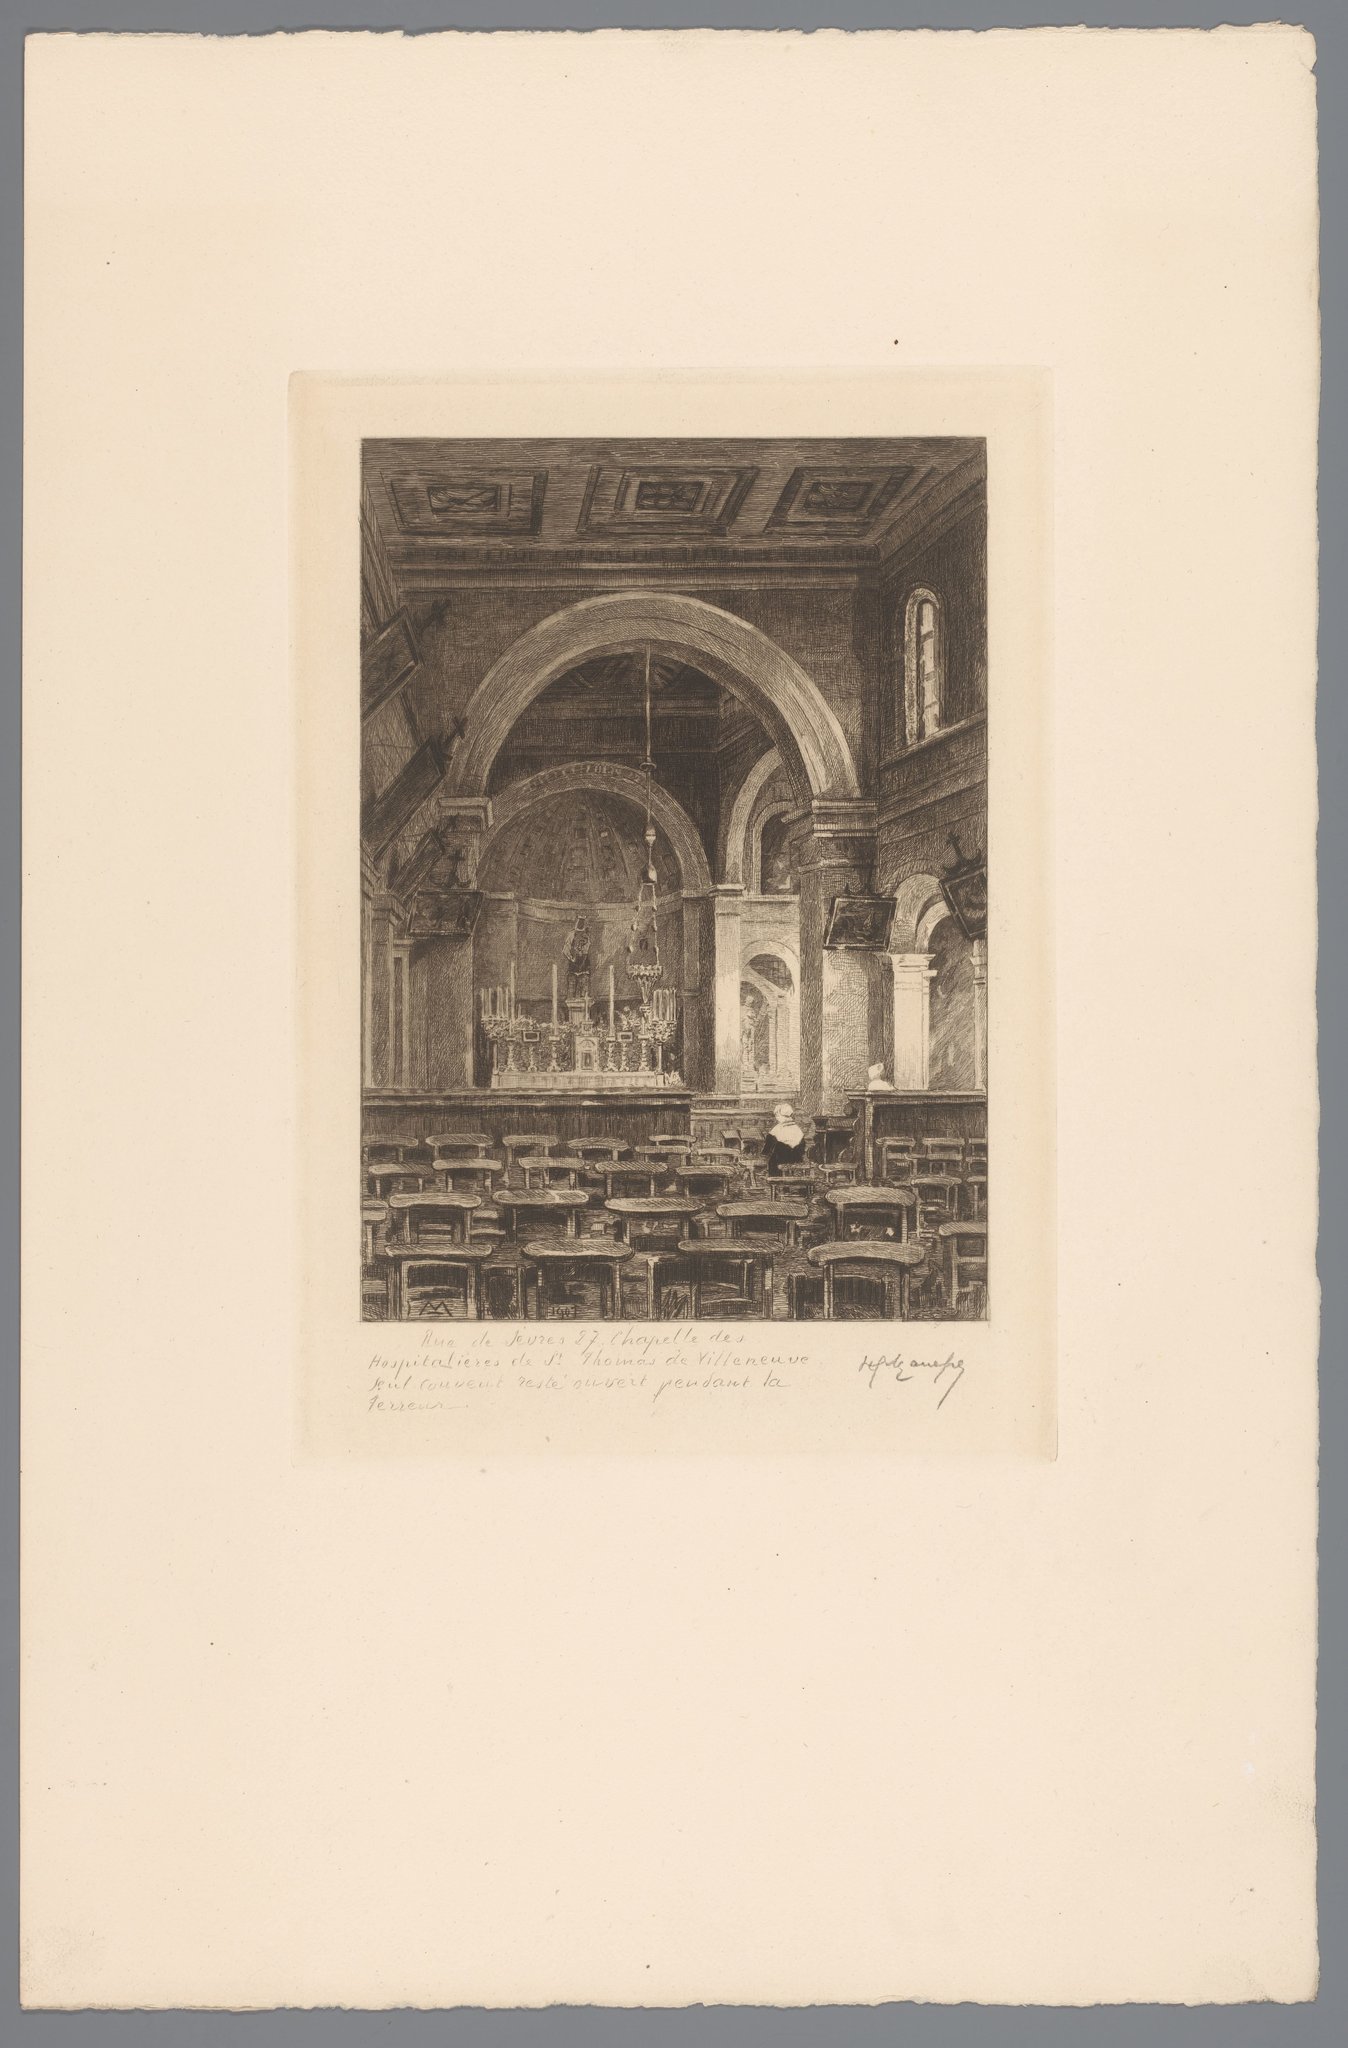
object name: print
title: Interieur van de Chapelle Hospitalières de St. Thomas de Villeneuve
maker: henri manesse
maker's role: print maker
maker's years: 1854-1940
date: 1907-1911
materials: paper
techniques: drypoint, engraving, etching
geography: france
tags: parts of church interior: chapel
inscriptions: collector's mark: Lugt 2228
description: Dit is de eerste serie uit een prentreeks die uit minstens elf series bestaat.